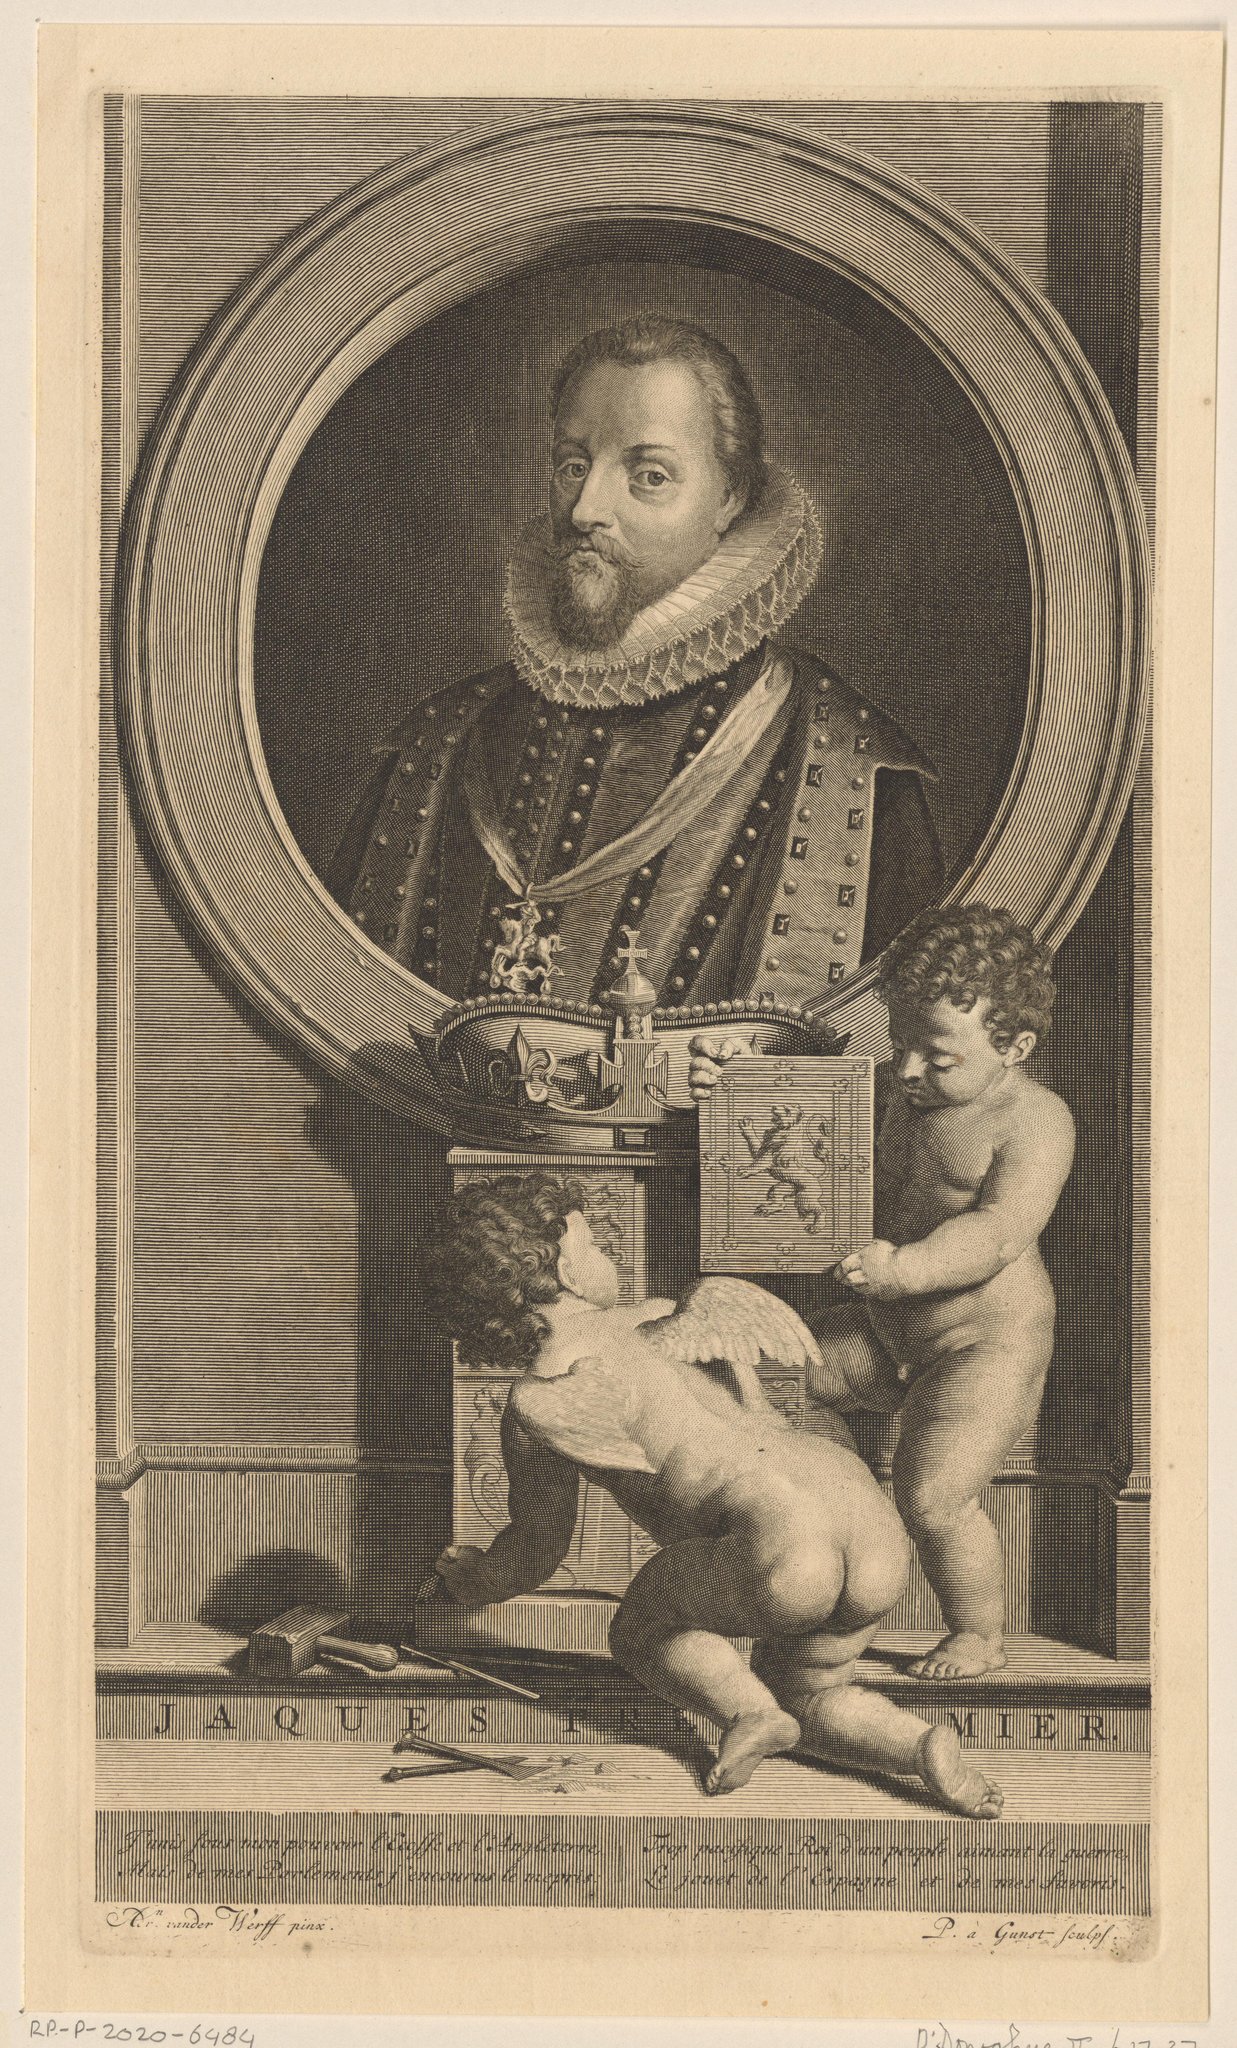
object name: print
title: Portret van Jacobus I, koning van Engeland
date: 1698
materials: paper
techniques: engraving, etching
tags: jacobus i (koning van engeland), crown (symbol of sovereignty), historical persons, angel(s) represented as child(ren), king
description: Prent mogelijk uit: Larrey, Isaac de. Histoire d'Angleterre, d'Ecosse et d'Irlande. Rotterdam: Reinier Leers, 1698, dl. 2.